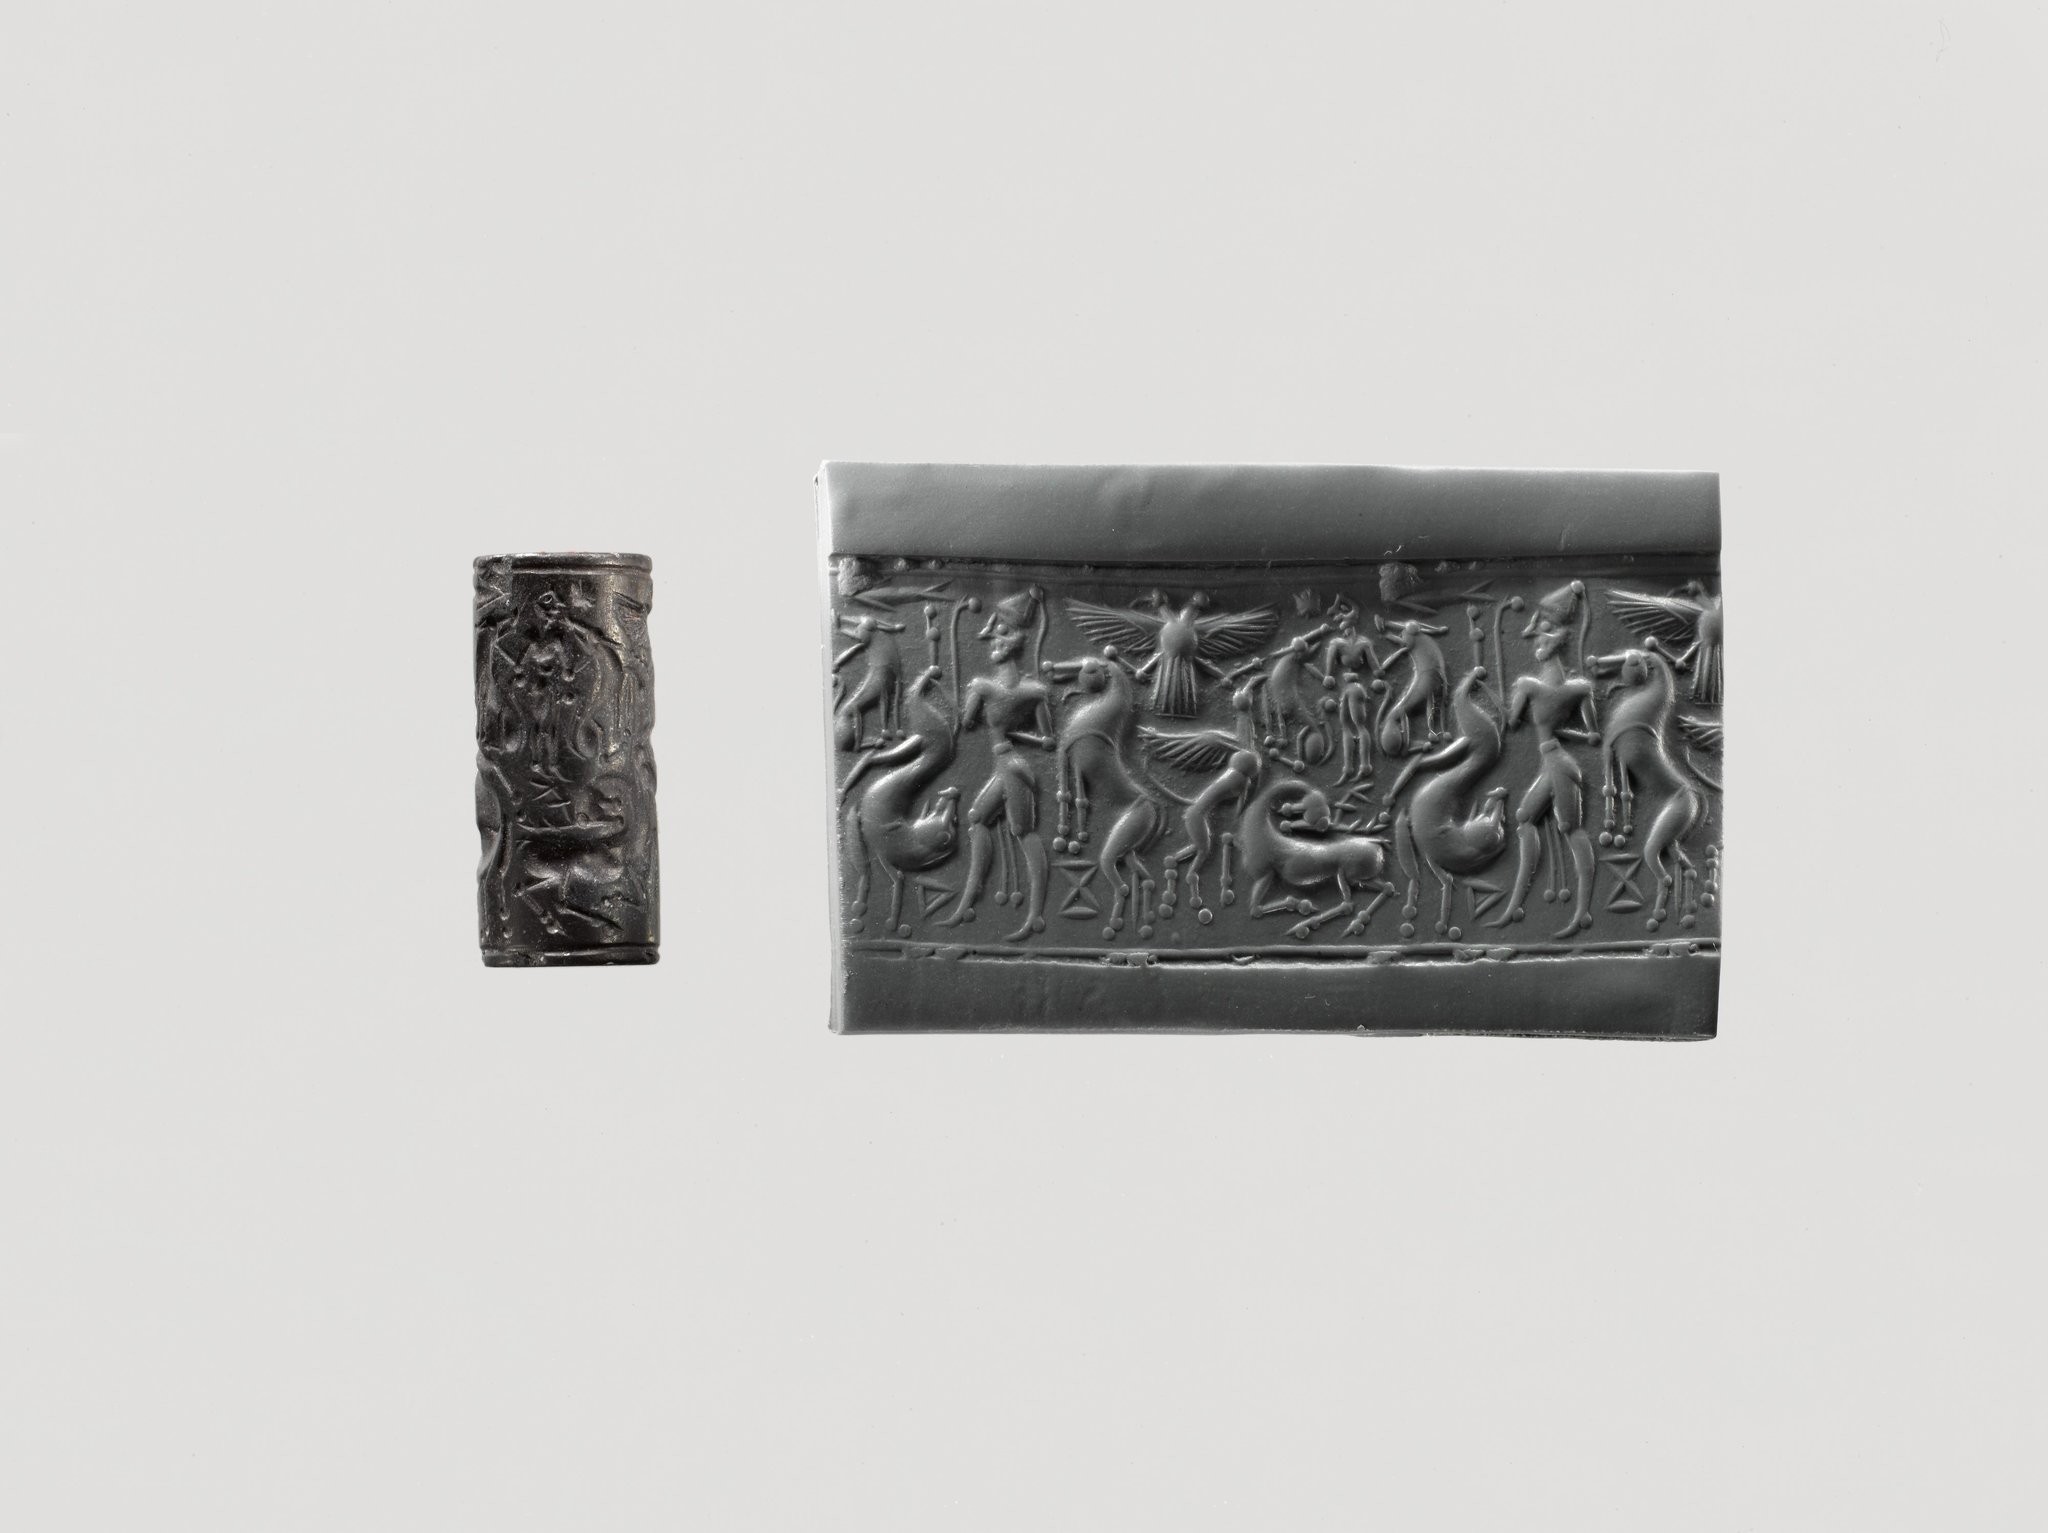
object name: cylinder seal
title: Cylinder seal and modern impression: hunter holding a lion; griffin attacking a stag; Master of Animals; double-headed eagle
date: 1400-1301 BCE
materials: mineral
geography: eastern mediterranean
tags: men,griffins,lions